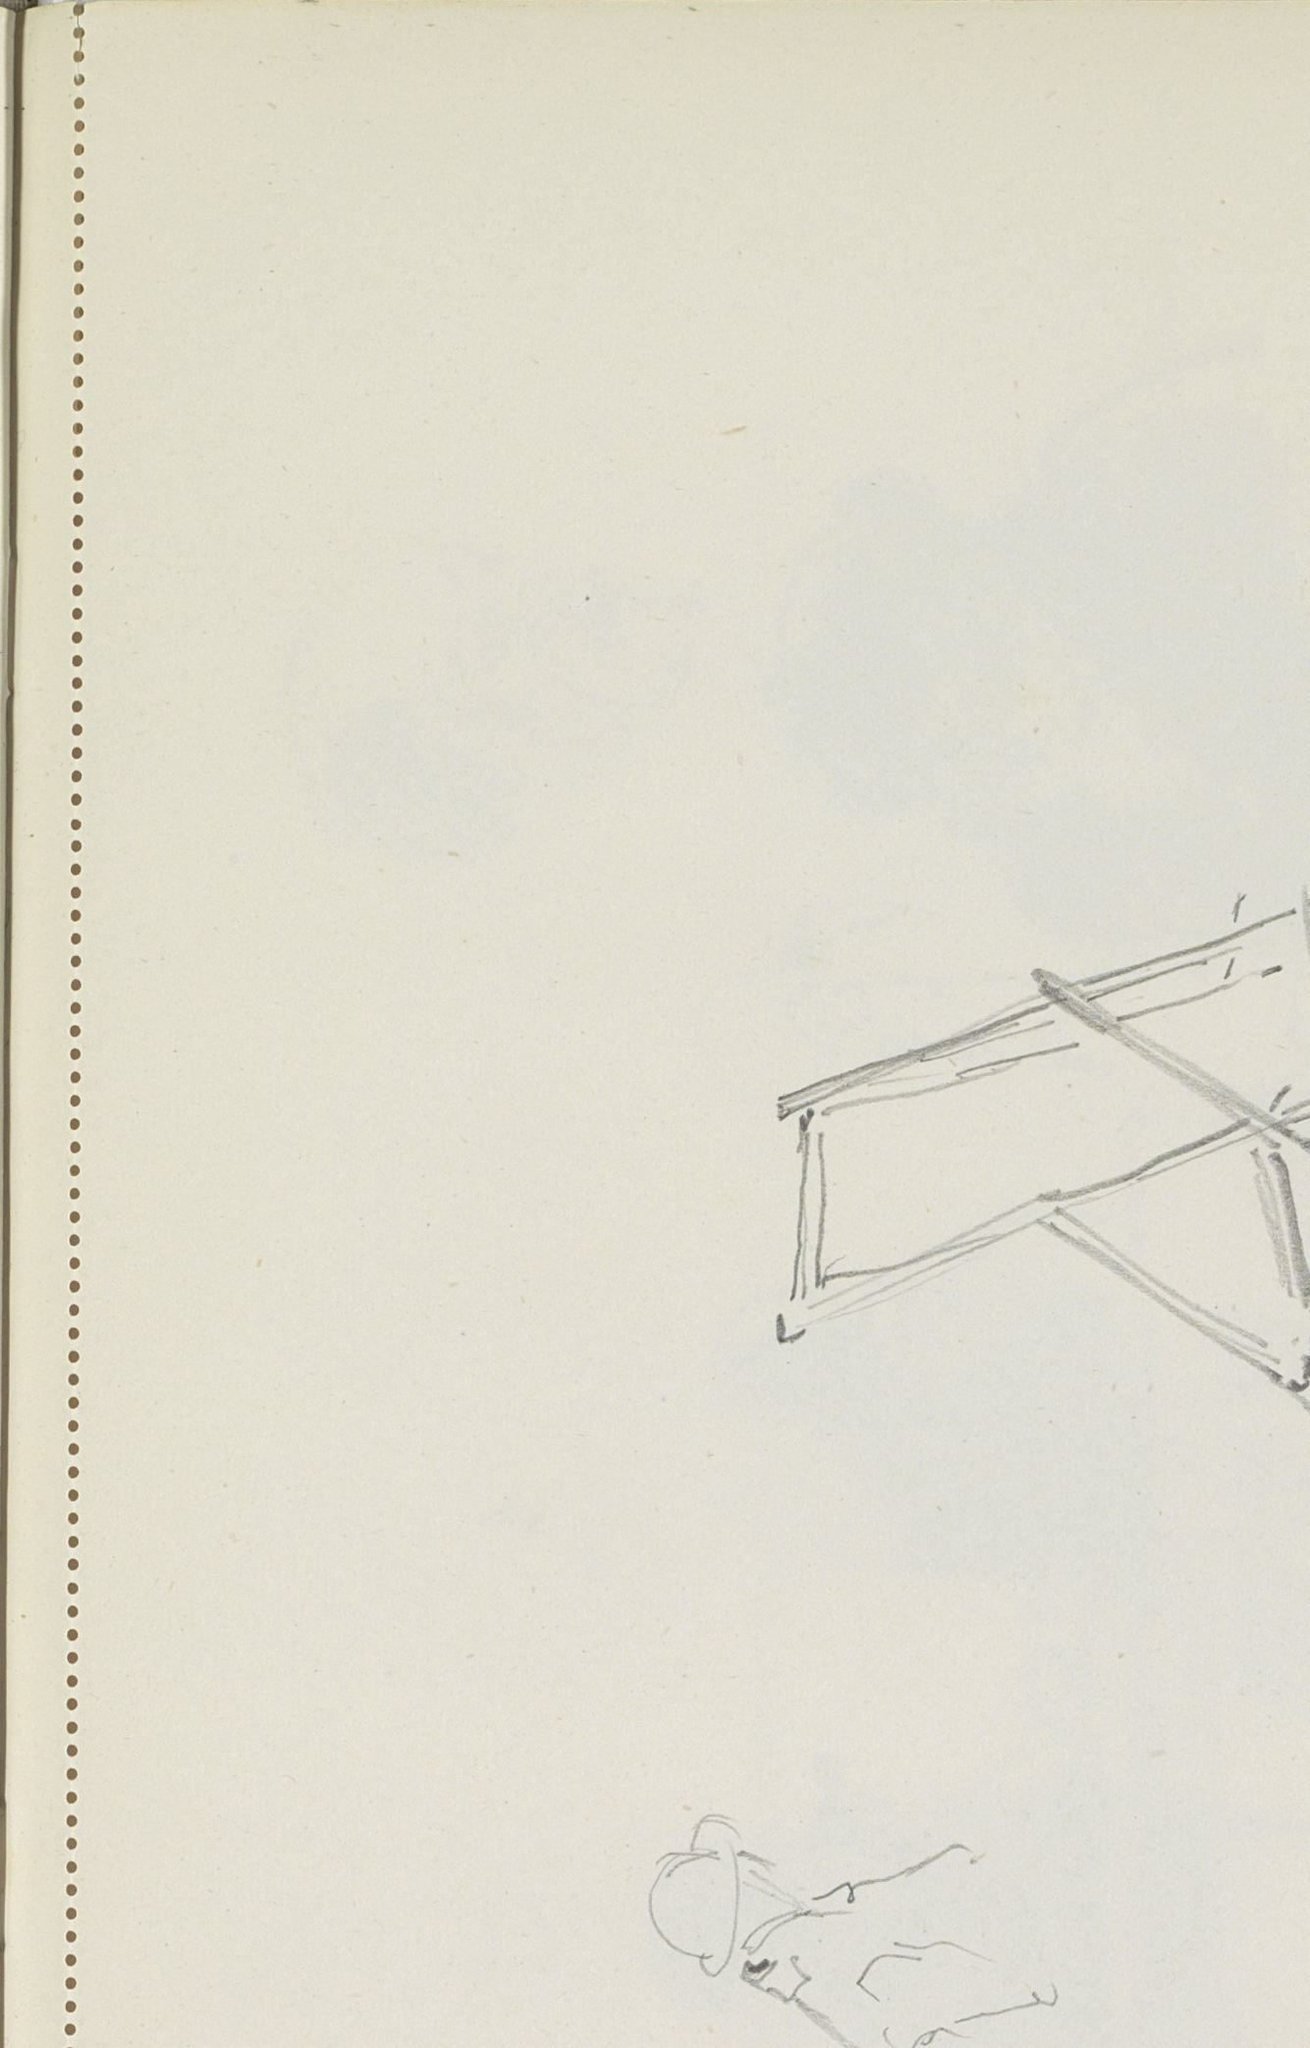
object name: sketchbook leaf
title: Strandstoel en een figuur met een hoed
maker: cornelis vreedenburgh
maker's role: draughtsman, print maker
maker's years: 1880-1946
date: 1890-1946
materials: paper, pencil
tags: head-gear: hat, chair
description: Blad 35 recto uit een schetsboek met 50 bladen.